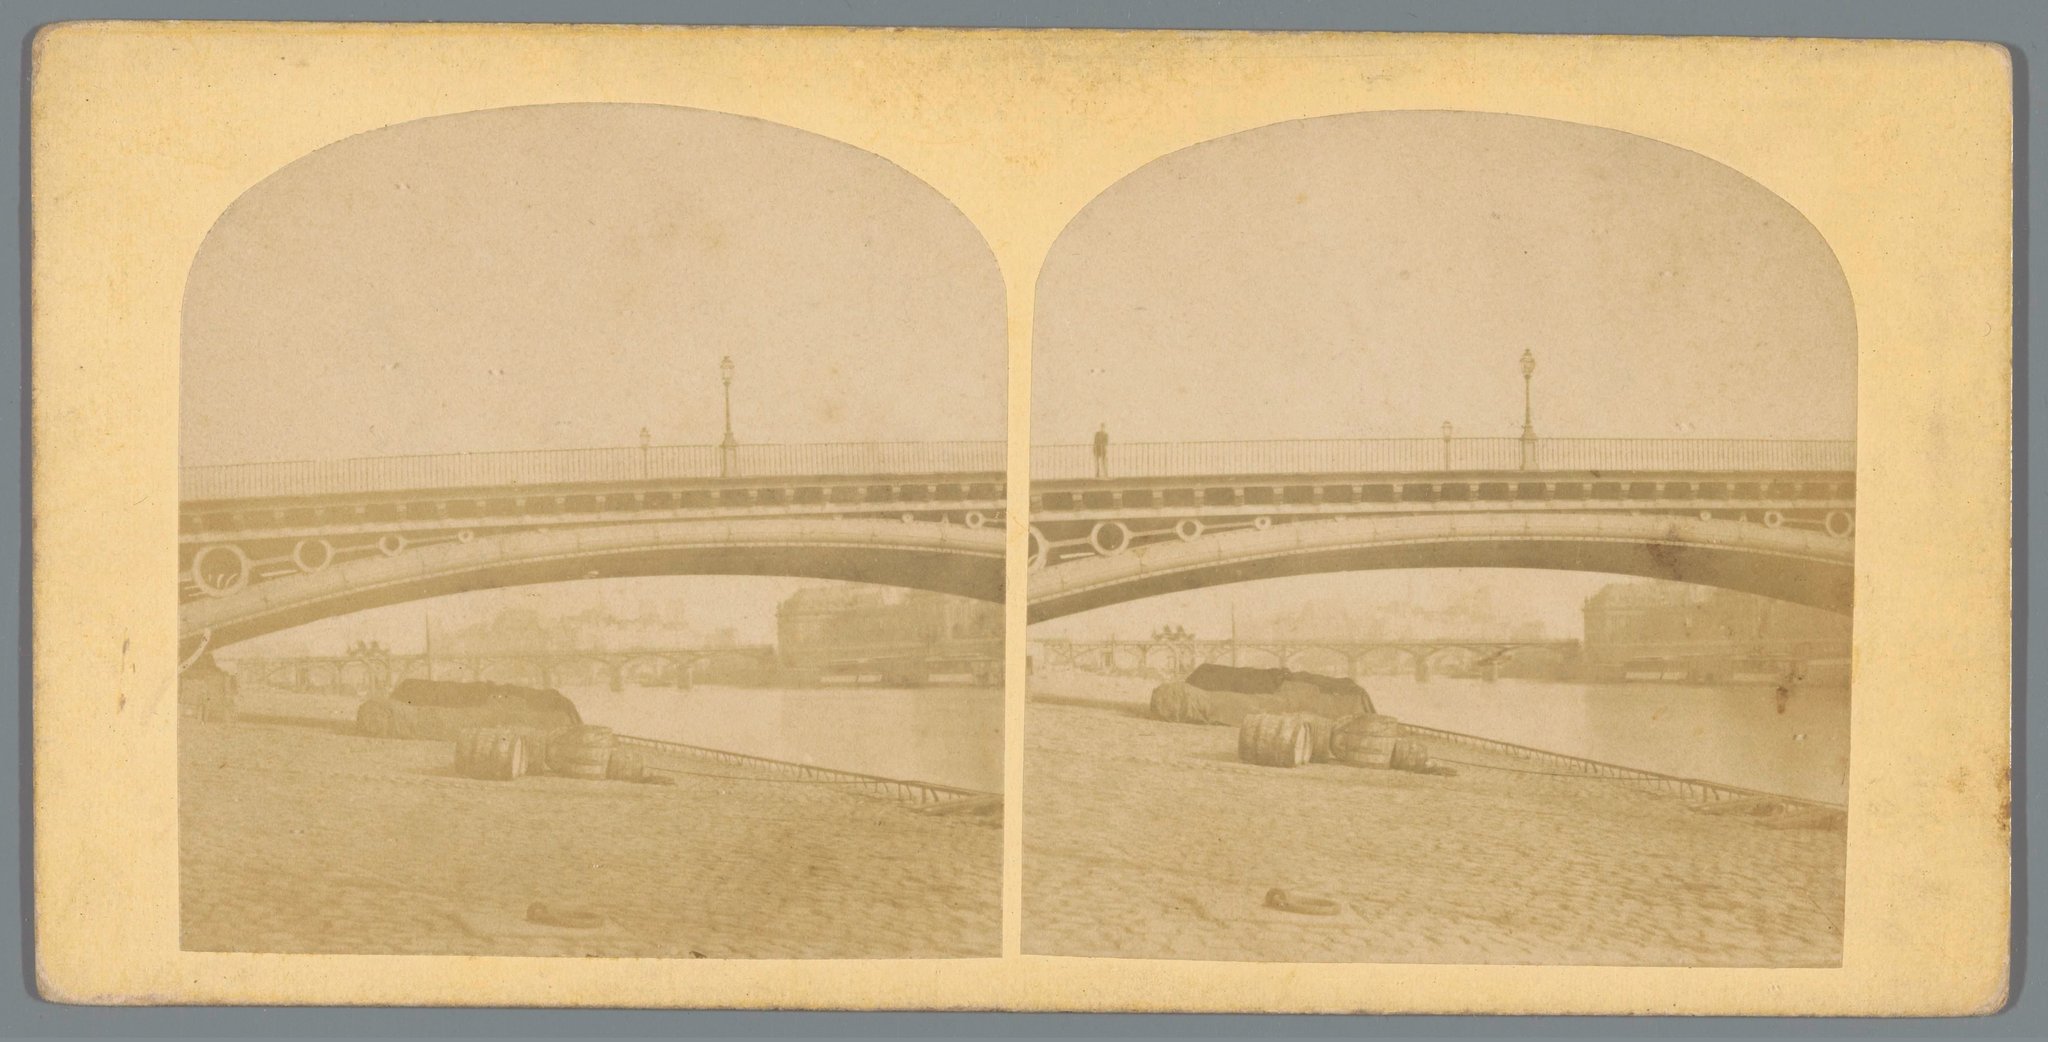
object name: stereograph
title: Gezicht op een kade en de Pont du Carrousel in Parijs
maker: Anonymous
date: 1860-1865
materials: cardboard, photographic support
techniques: albumen print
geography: paris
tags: bridge in city across river, canal, etc., quay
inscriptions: inscription: ‘Port du St Peres Pont du Carousel A.l.’